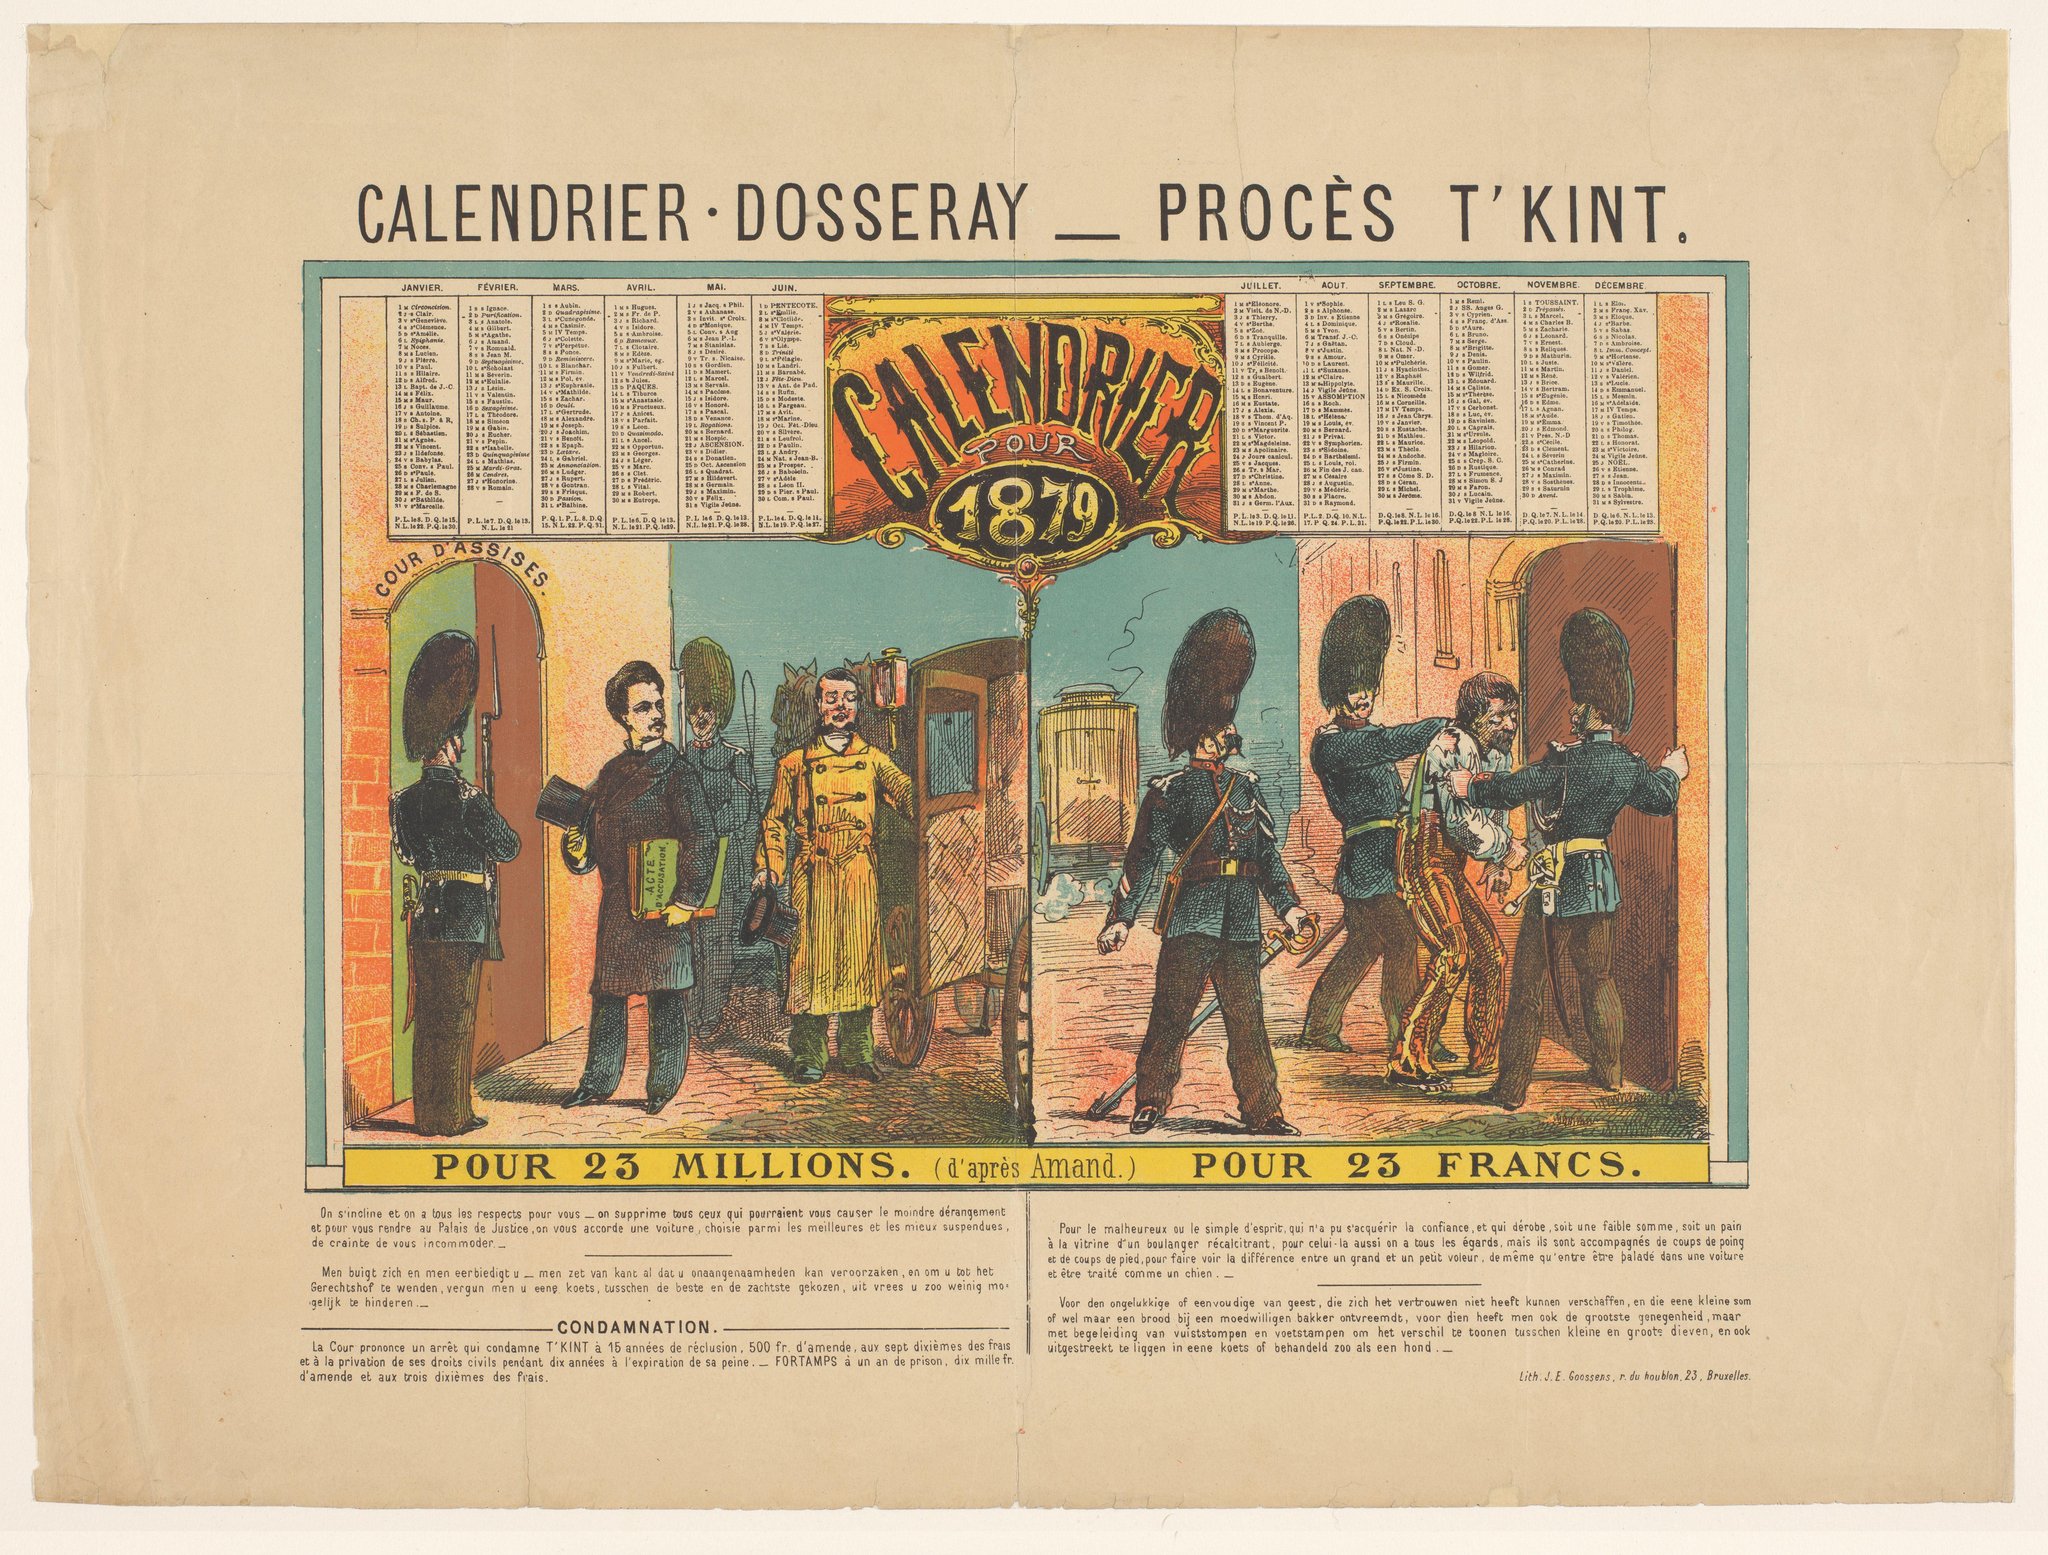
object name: print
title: Calendrier dosseray procès t'kint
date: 1879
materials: paper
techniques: lithograph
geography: brussels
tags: calendar, almanac, arrest (of criminal), passenger carriage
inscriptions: collector's mark: Lugt 2228